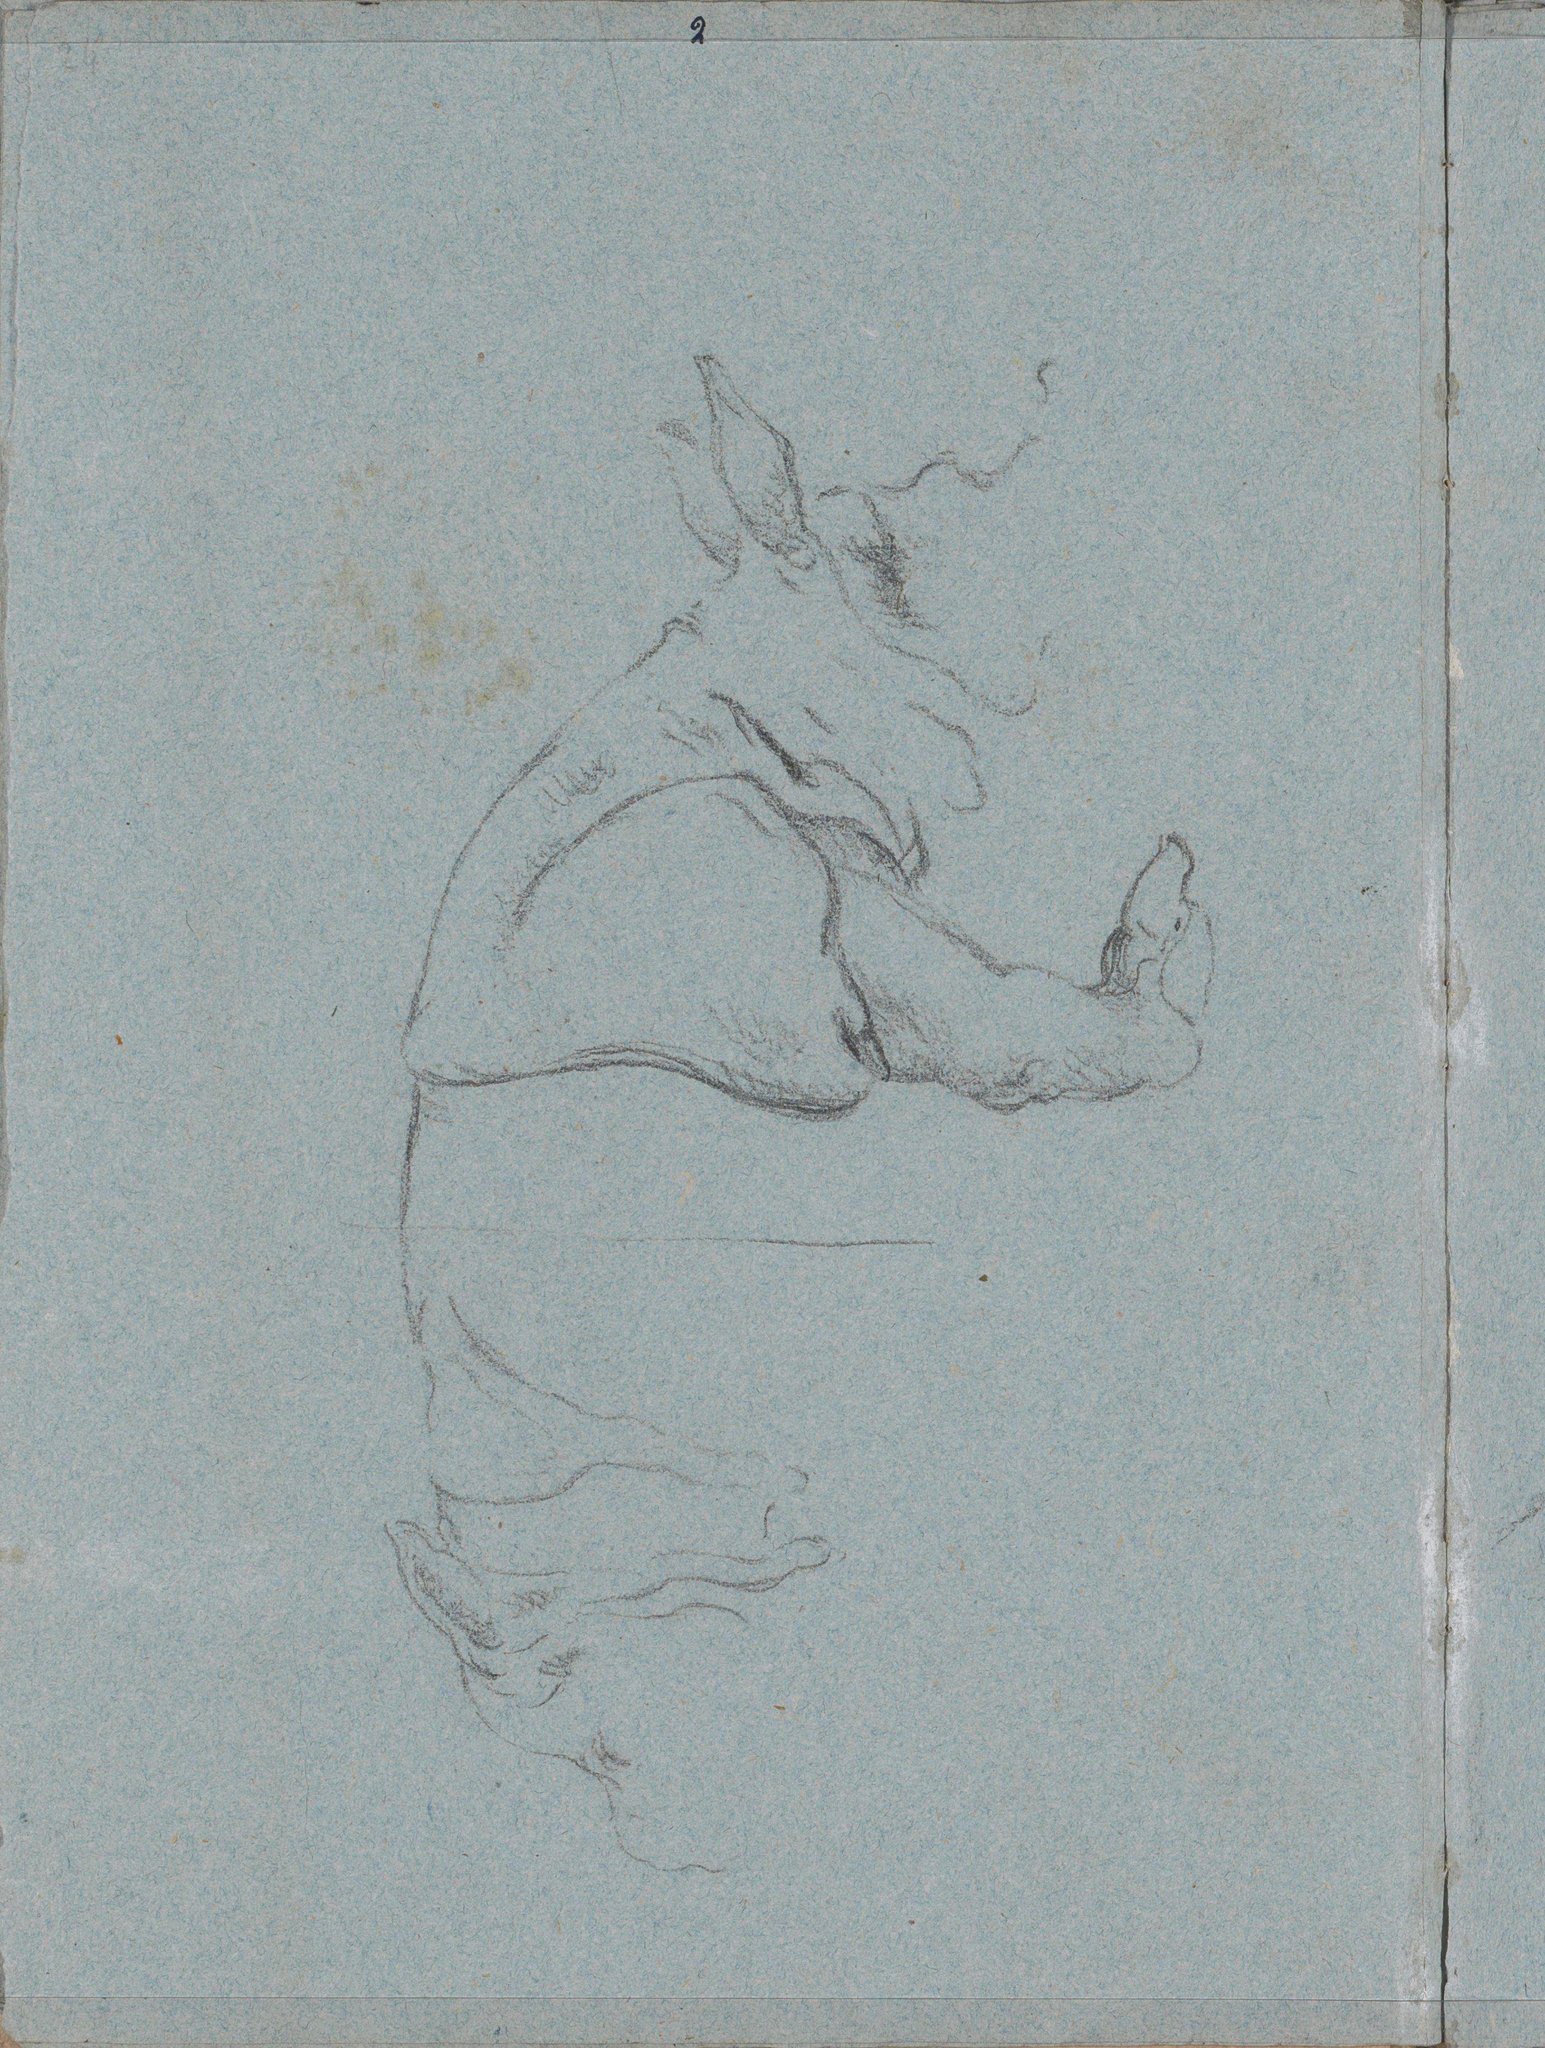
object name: sketchbook leaf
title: Voorste deel van neushoorn Clara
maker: lorenzo baldissera tiepolo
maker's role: draughtsman, print maker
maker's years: 1736-1776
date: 1751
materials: chalk, paper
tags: london, hoofed animals: rhinoceros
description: Twee gespiegelde studies van het voorste deel van de neushoorn. Bladzijde 24 uit een schetsboek met 158 bladzijden.